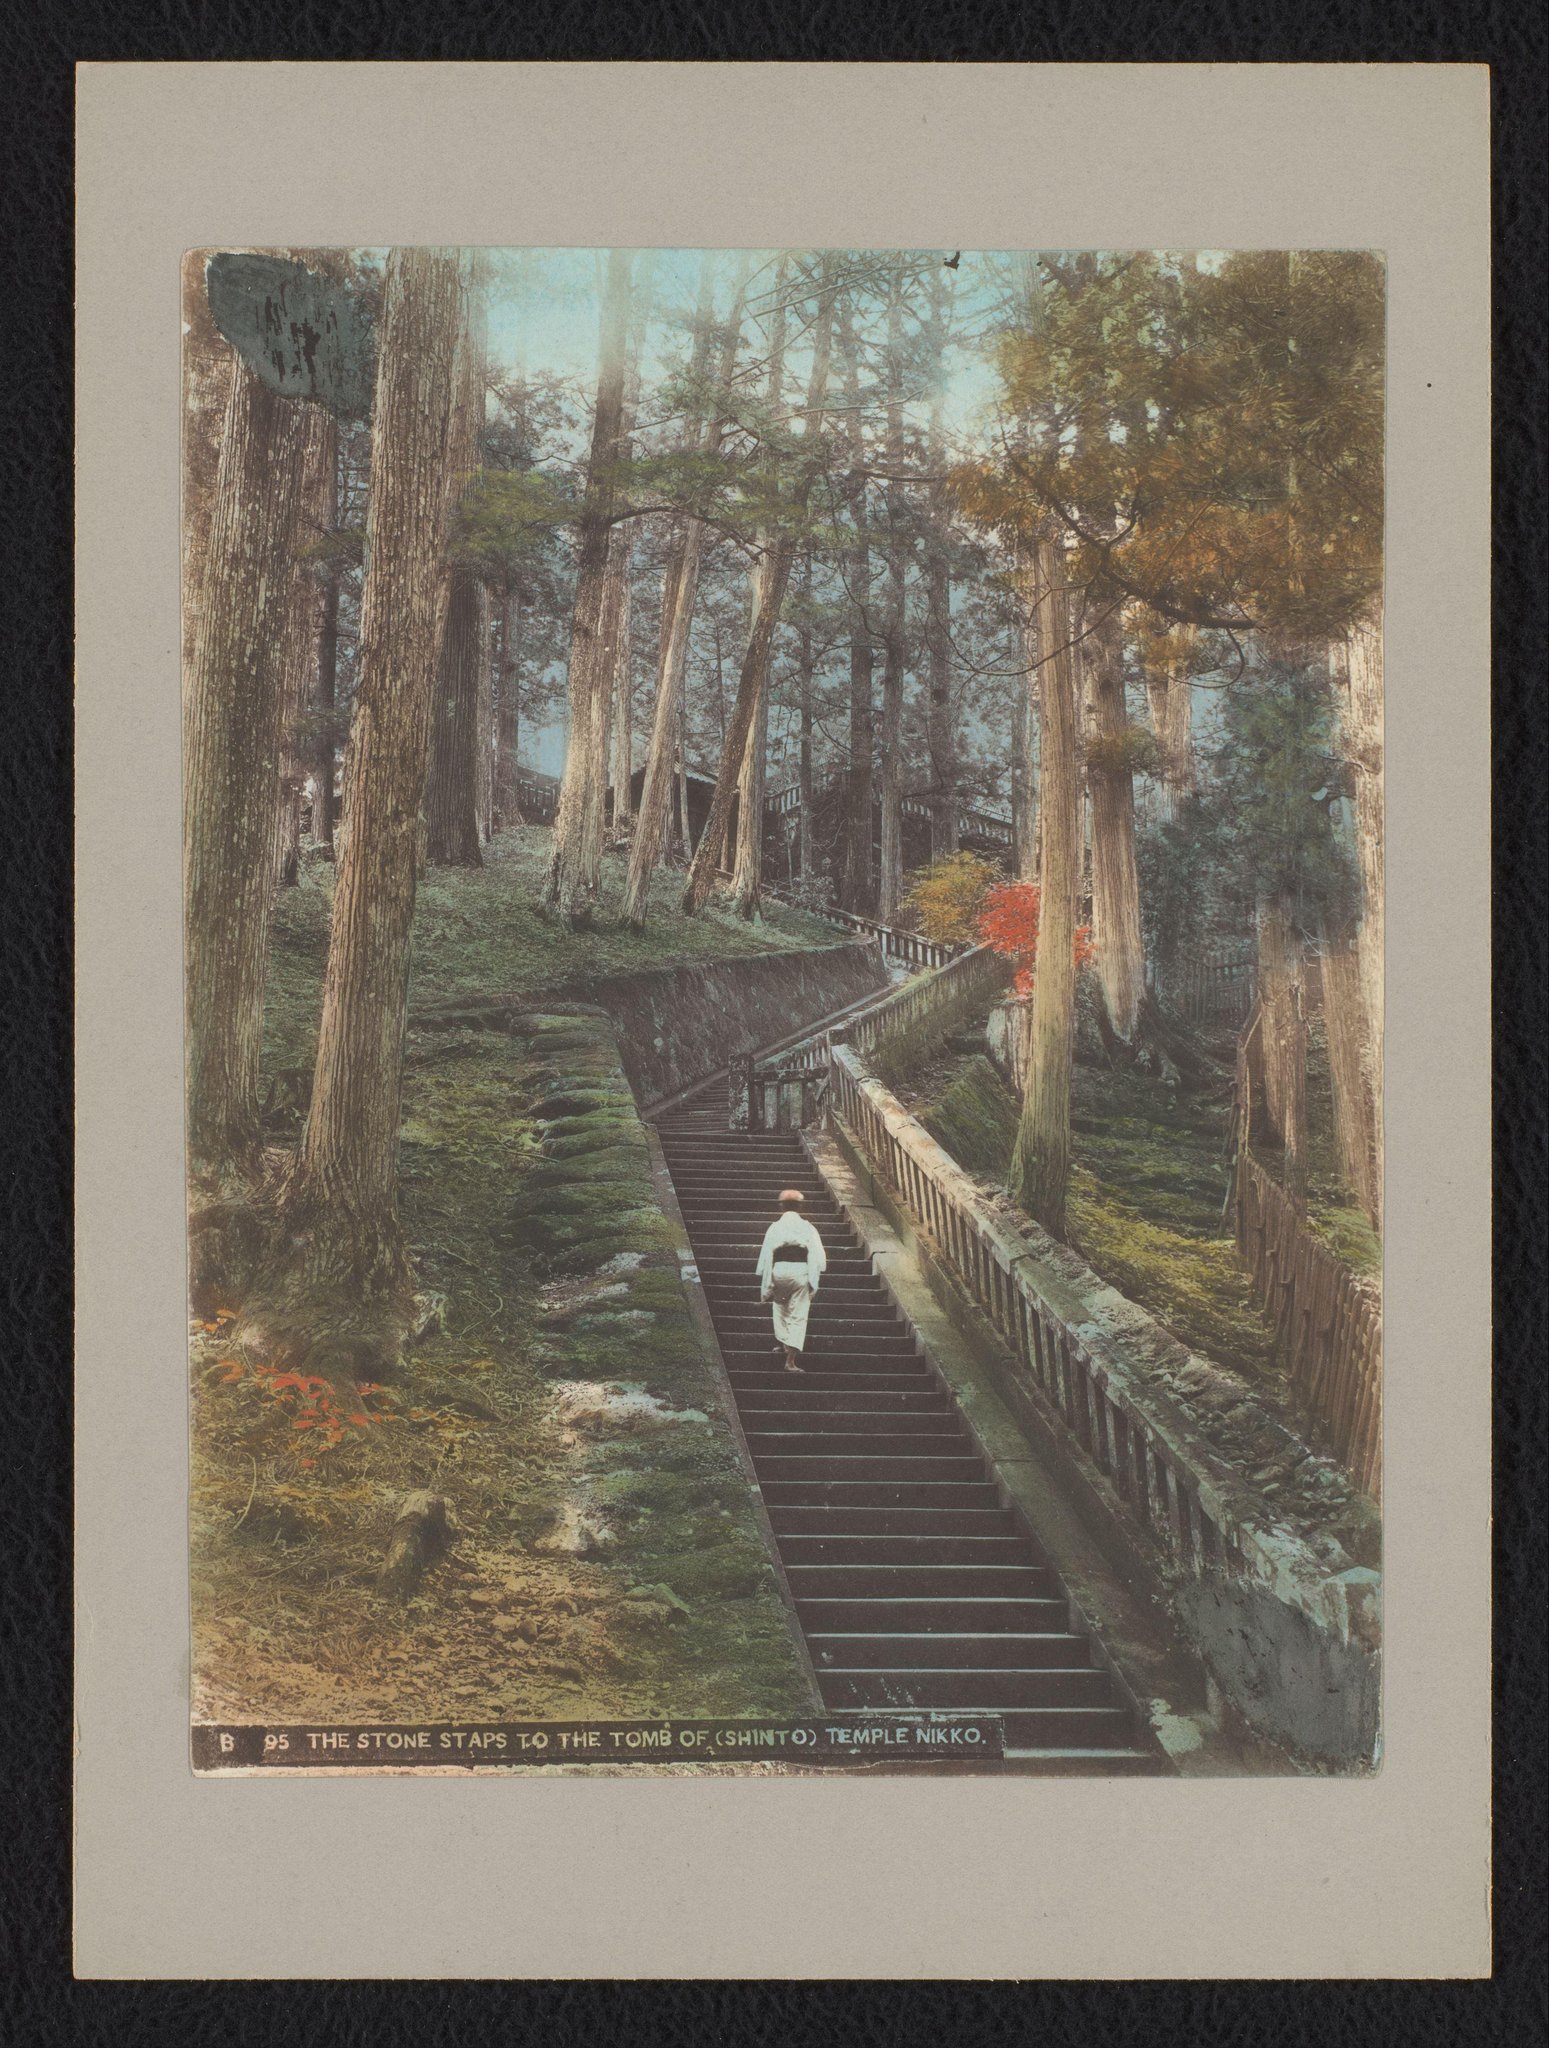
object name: photograph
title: Stenen trap naar de graftombe van shintoschrijn Nikko Toshogu, Nikko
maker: Anonymous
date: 1895-1915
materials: cardboard, photographic support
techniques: salted paper print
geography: nikko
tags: nikko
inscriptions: number: ‘37.’